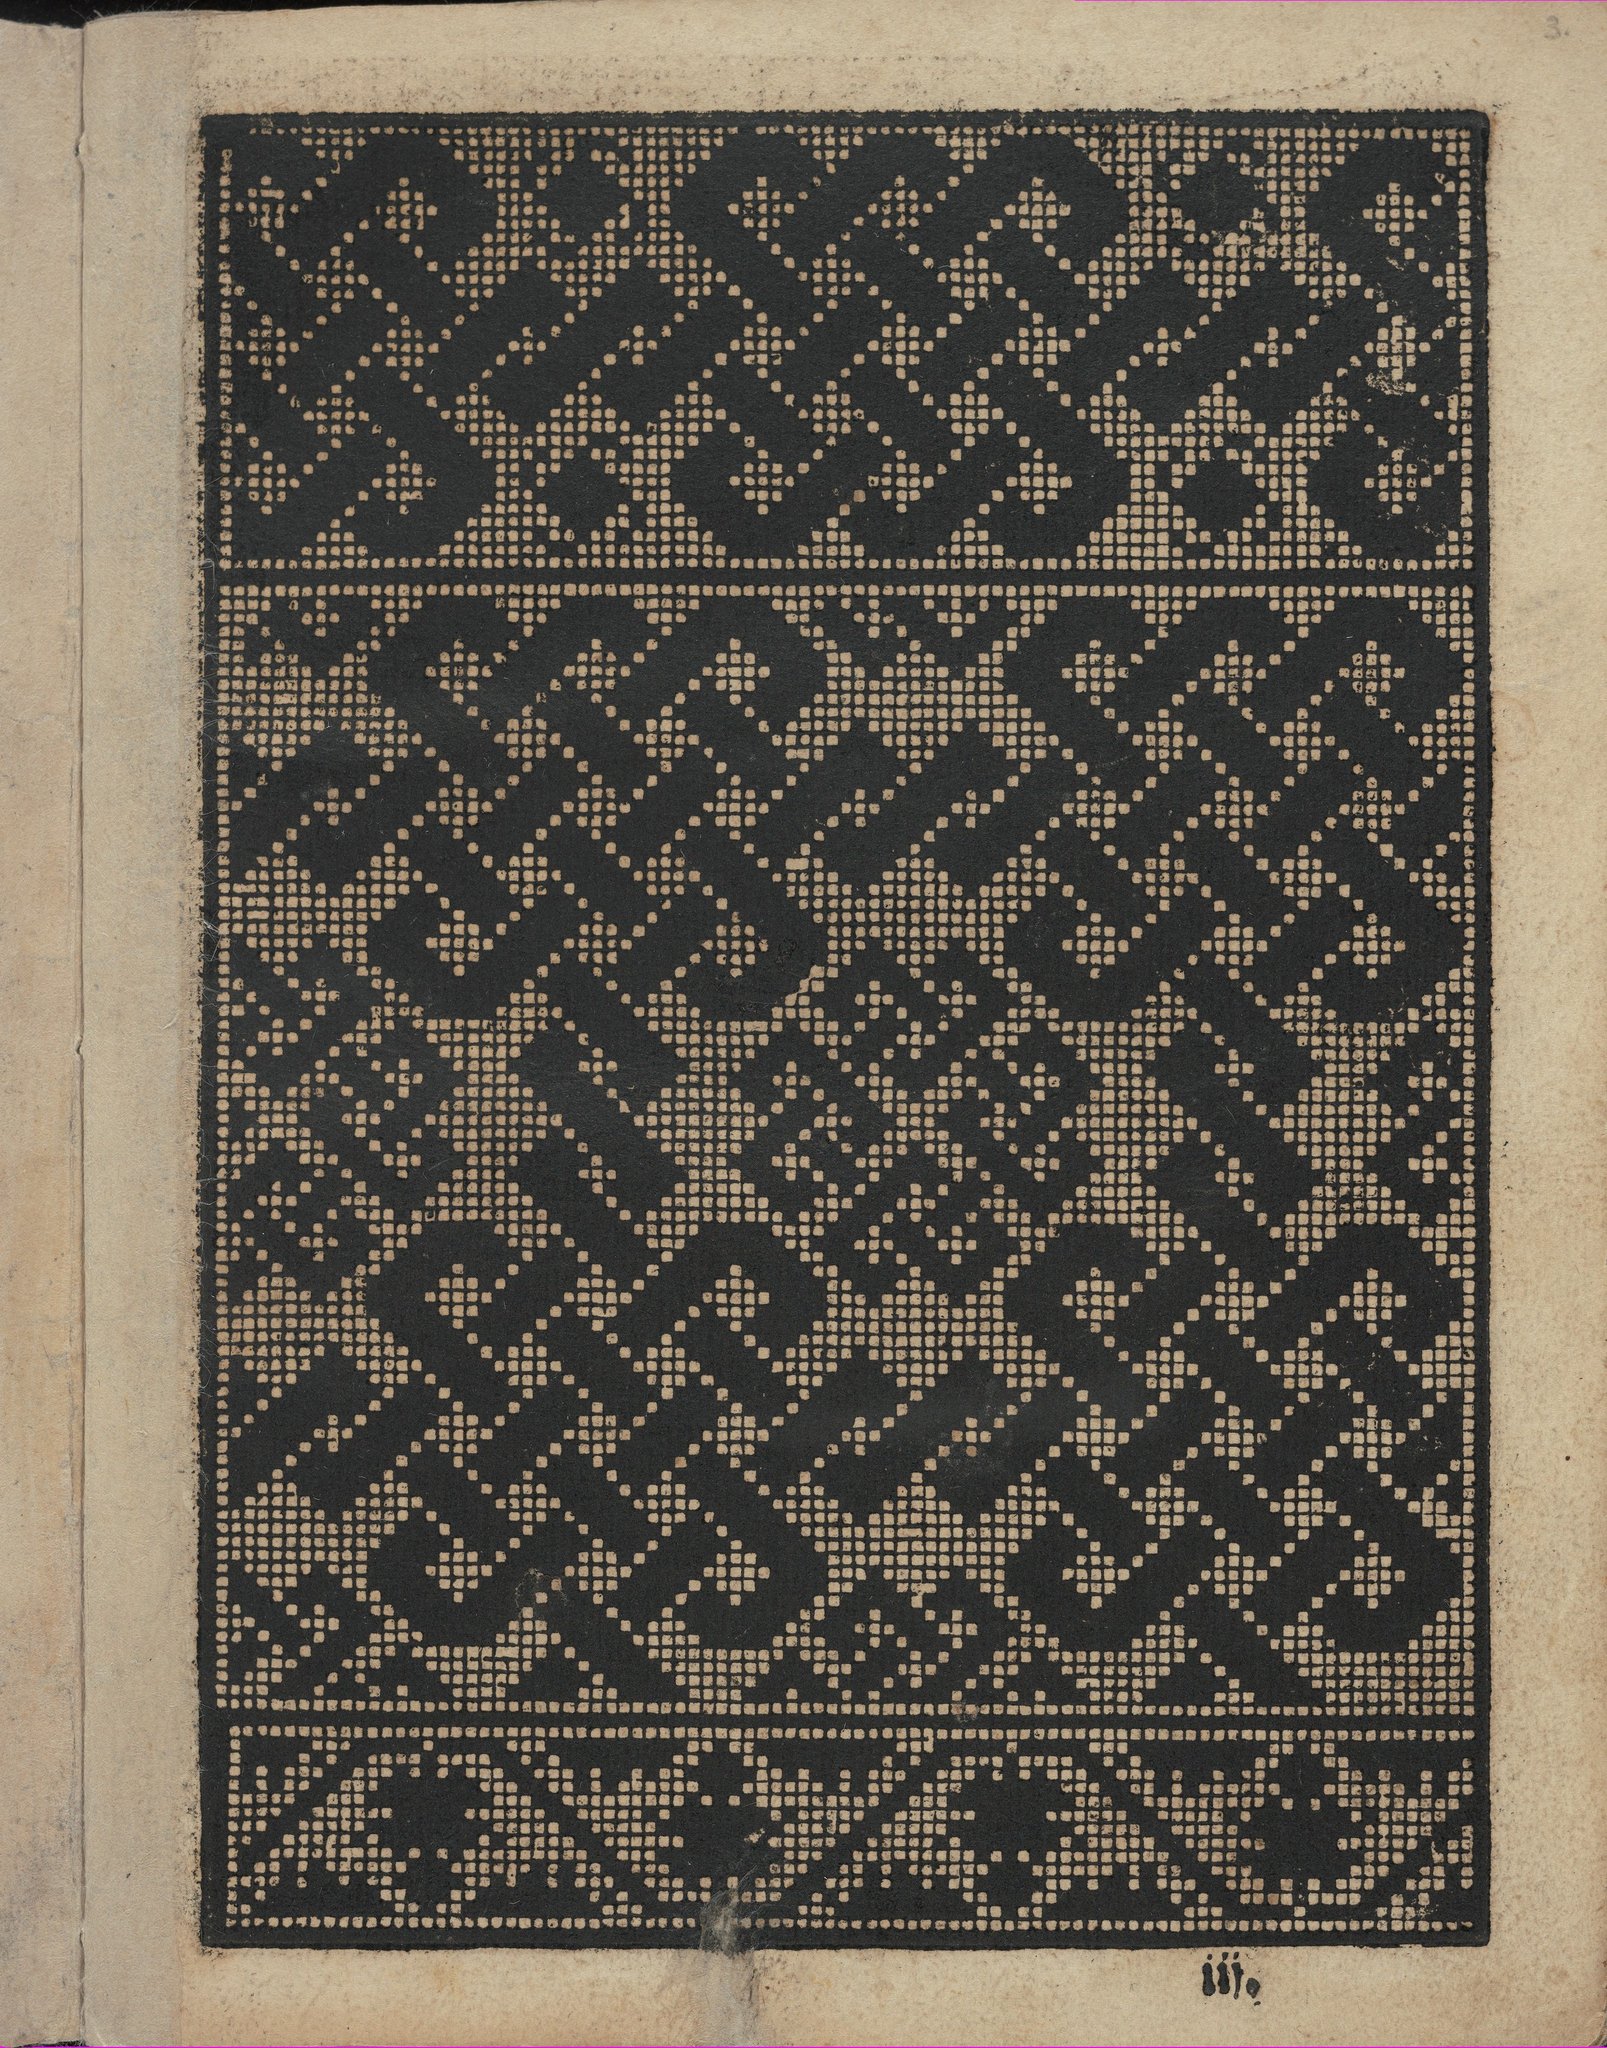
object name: book print ornament architecture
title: Libbretto nouellamete composto per maestro Domenico da Sera...lauorare di ogni sorte di punti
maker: domenico da sera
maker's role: publisher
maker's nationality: french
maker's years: 1500-1599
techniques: woodcut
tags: flowers